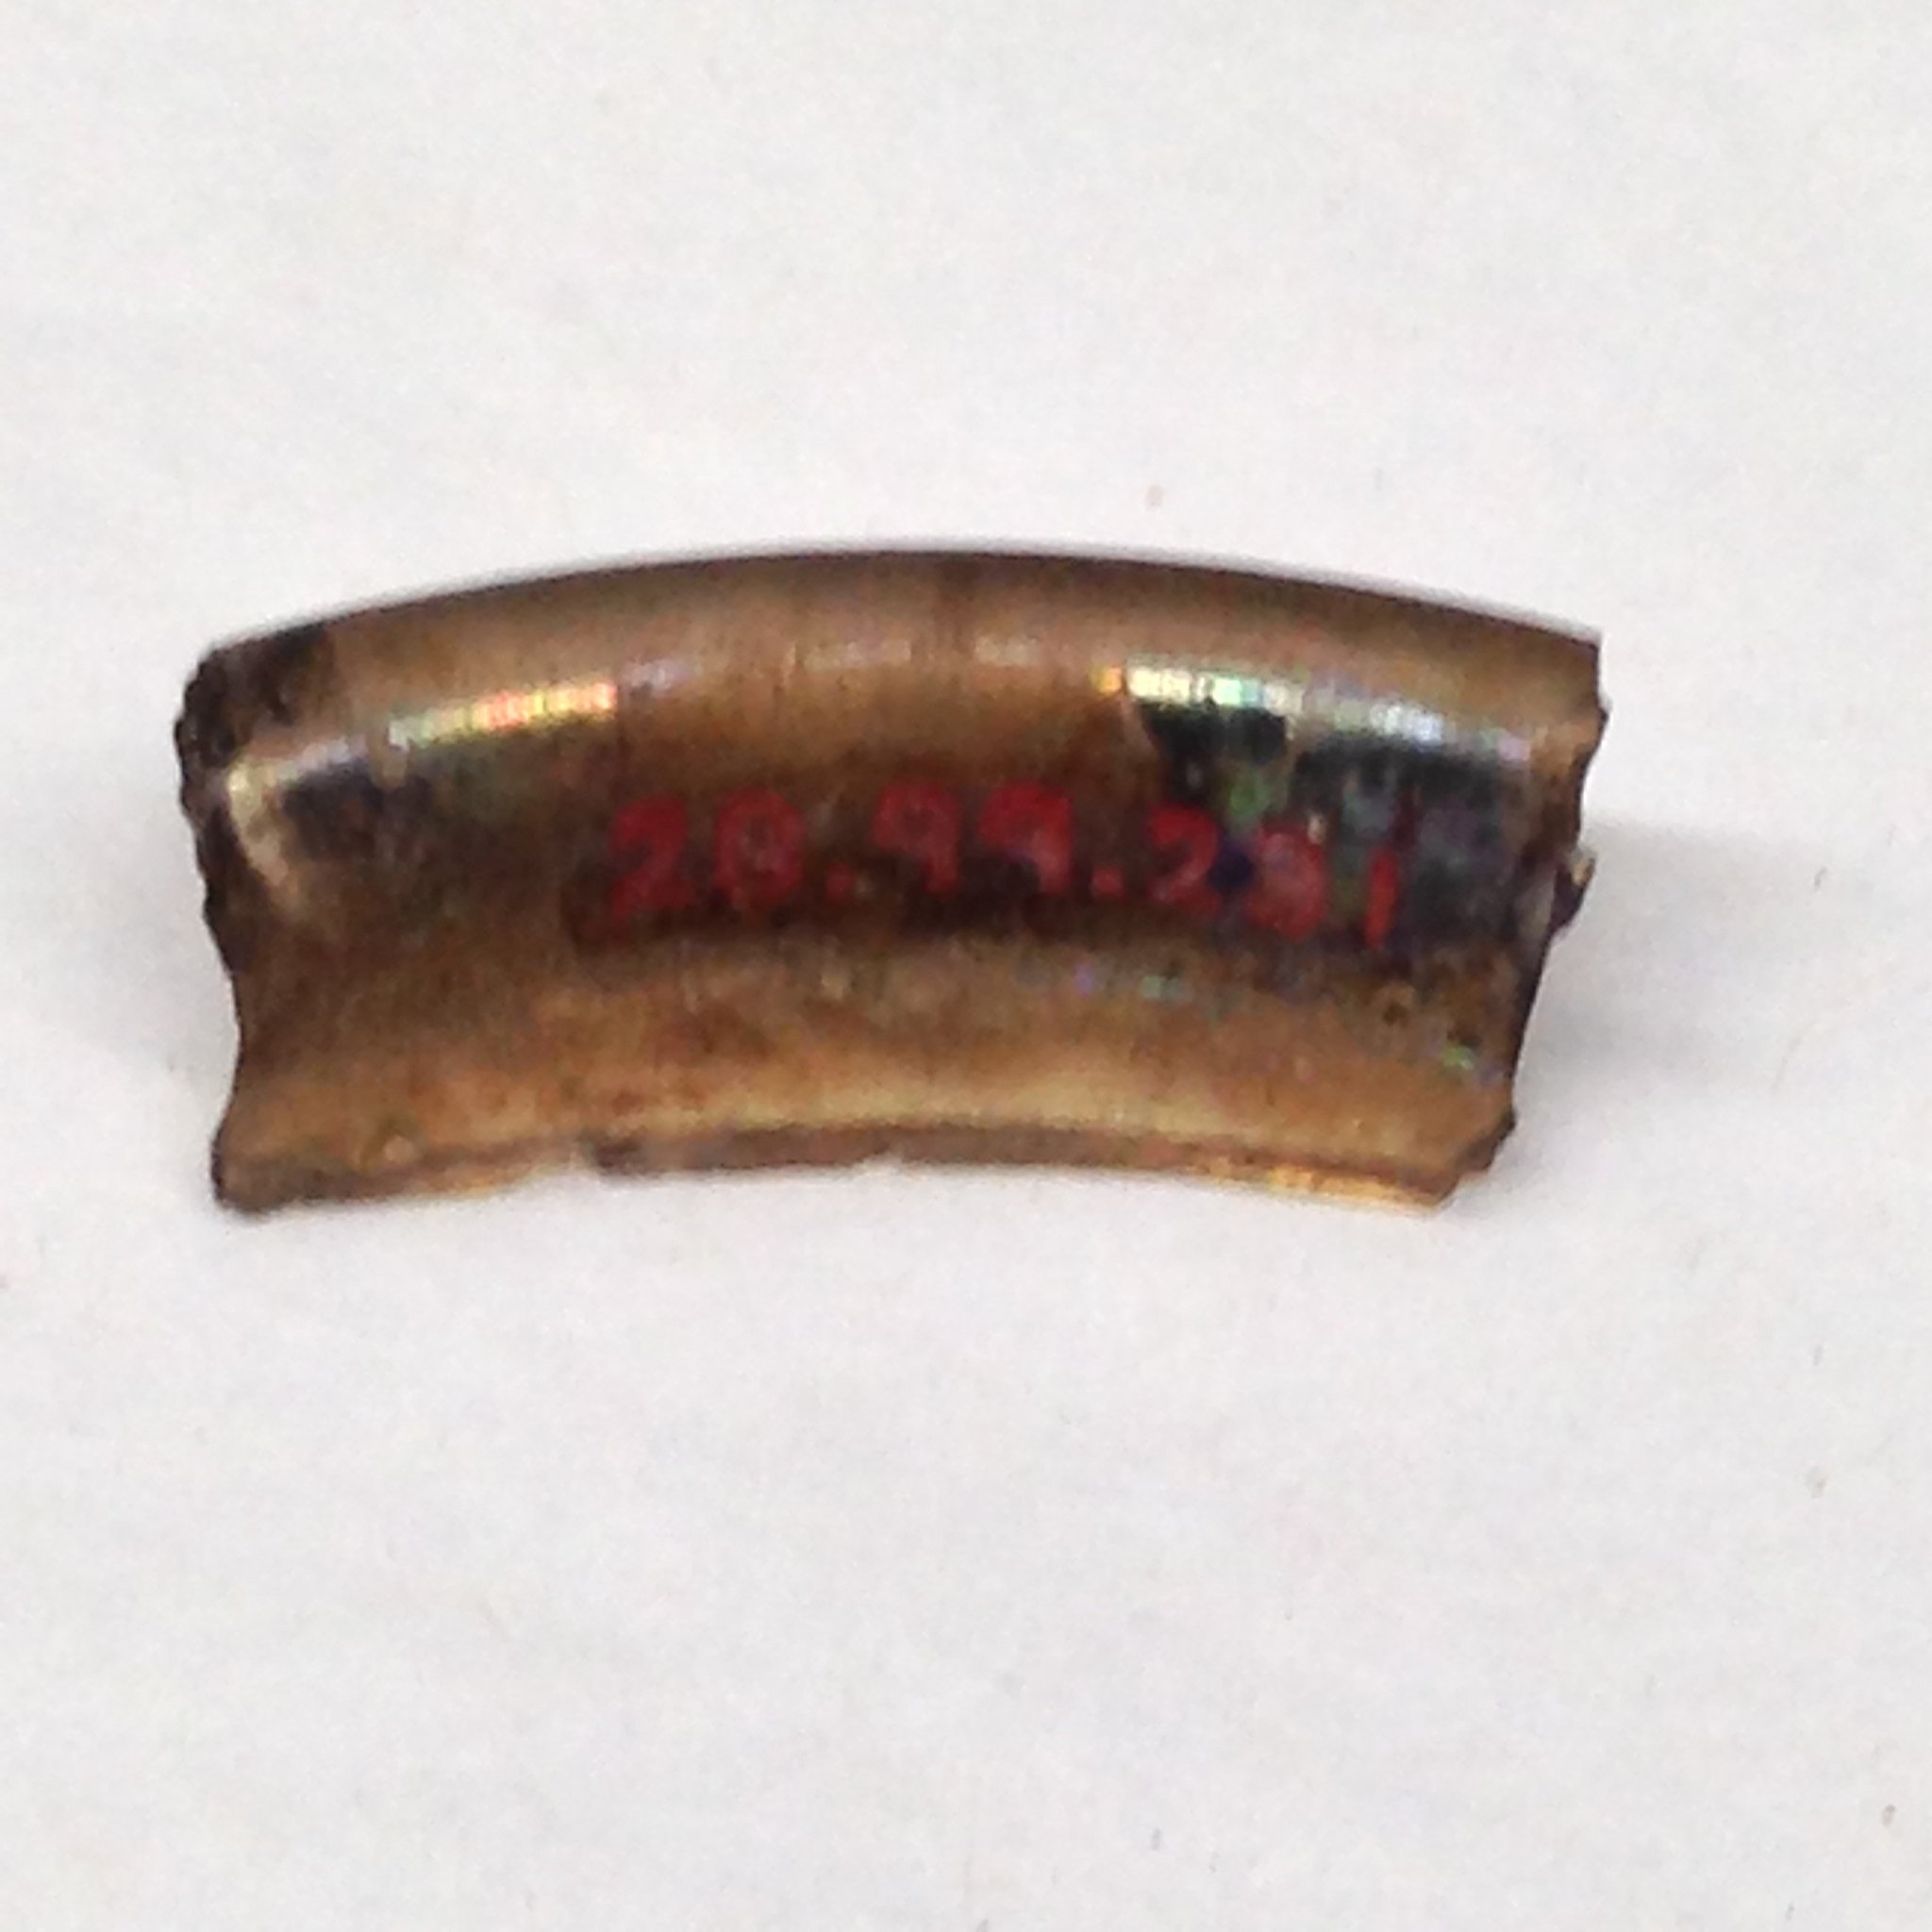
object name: fragment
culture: european or middle eastern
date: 1150-1250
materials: ceramic, glass